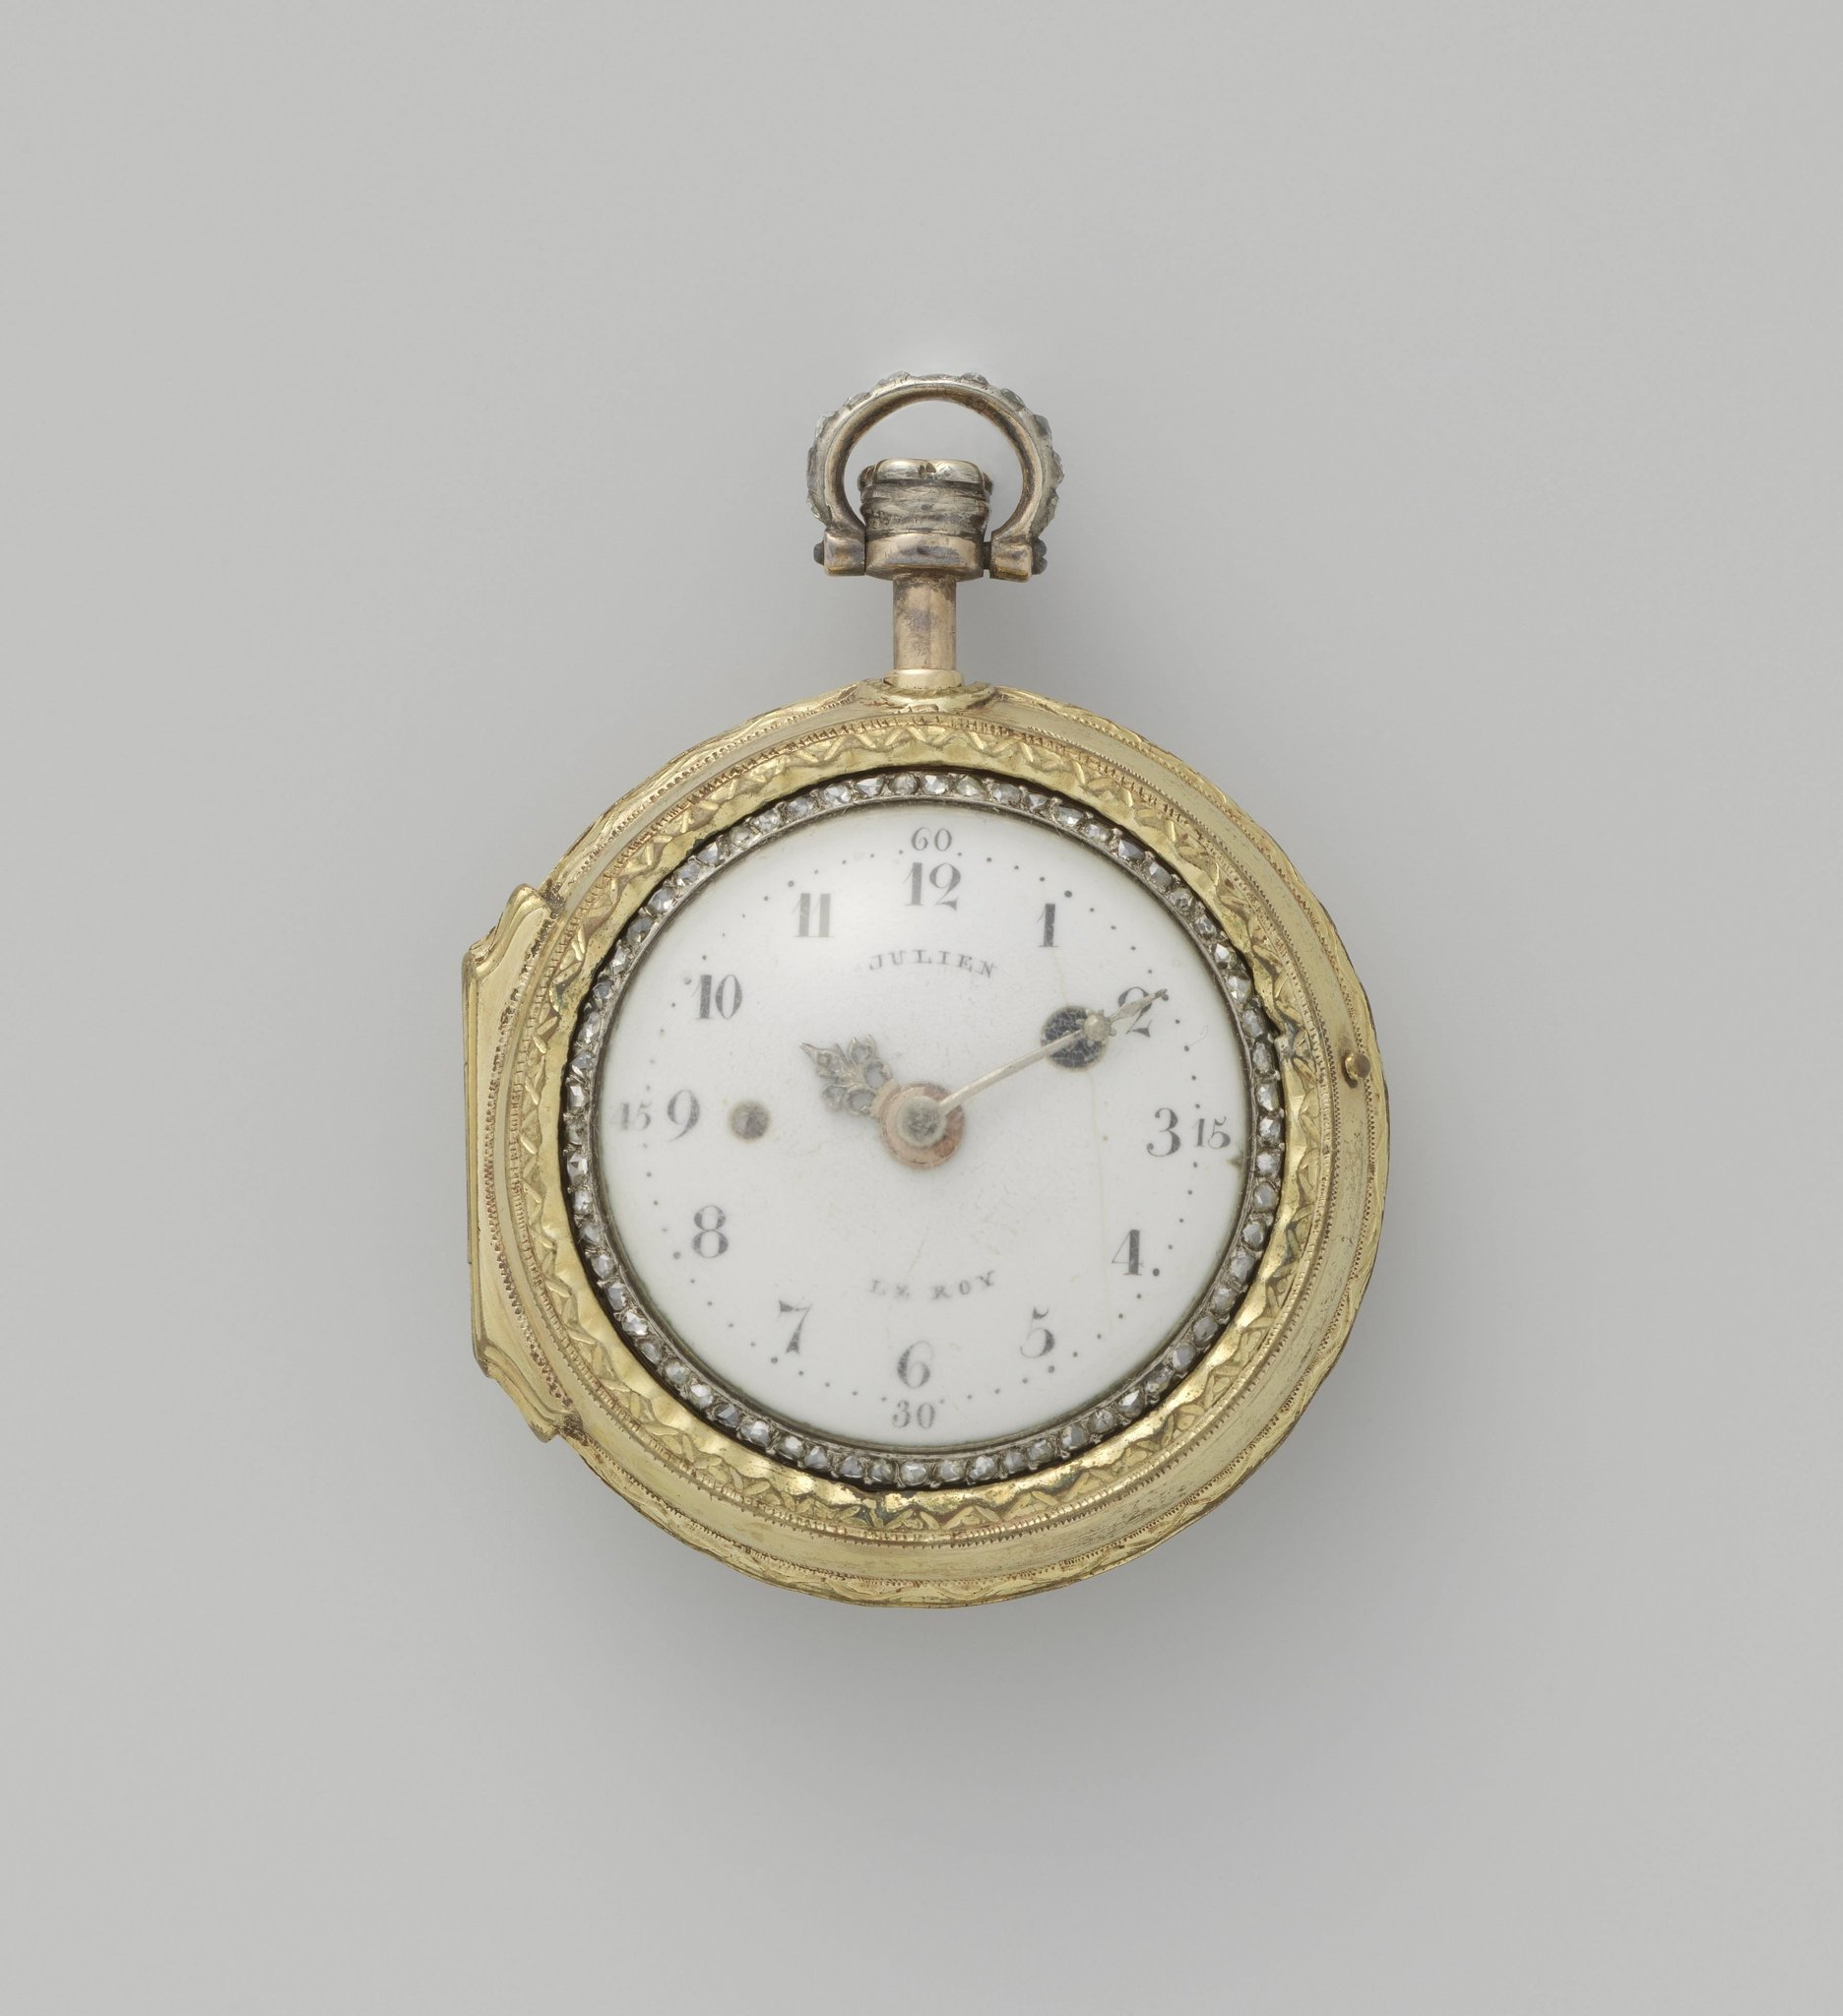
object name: dameshorloge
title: Repeating Watch with an Awakening Cupid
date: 1759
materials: diamond, gold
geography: paris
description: Repetitiehorloge van goud, met emailschildering voorstellende een ontwakende amor. Langs het glas een rand van diamantjes.